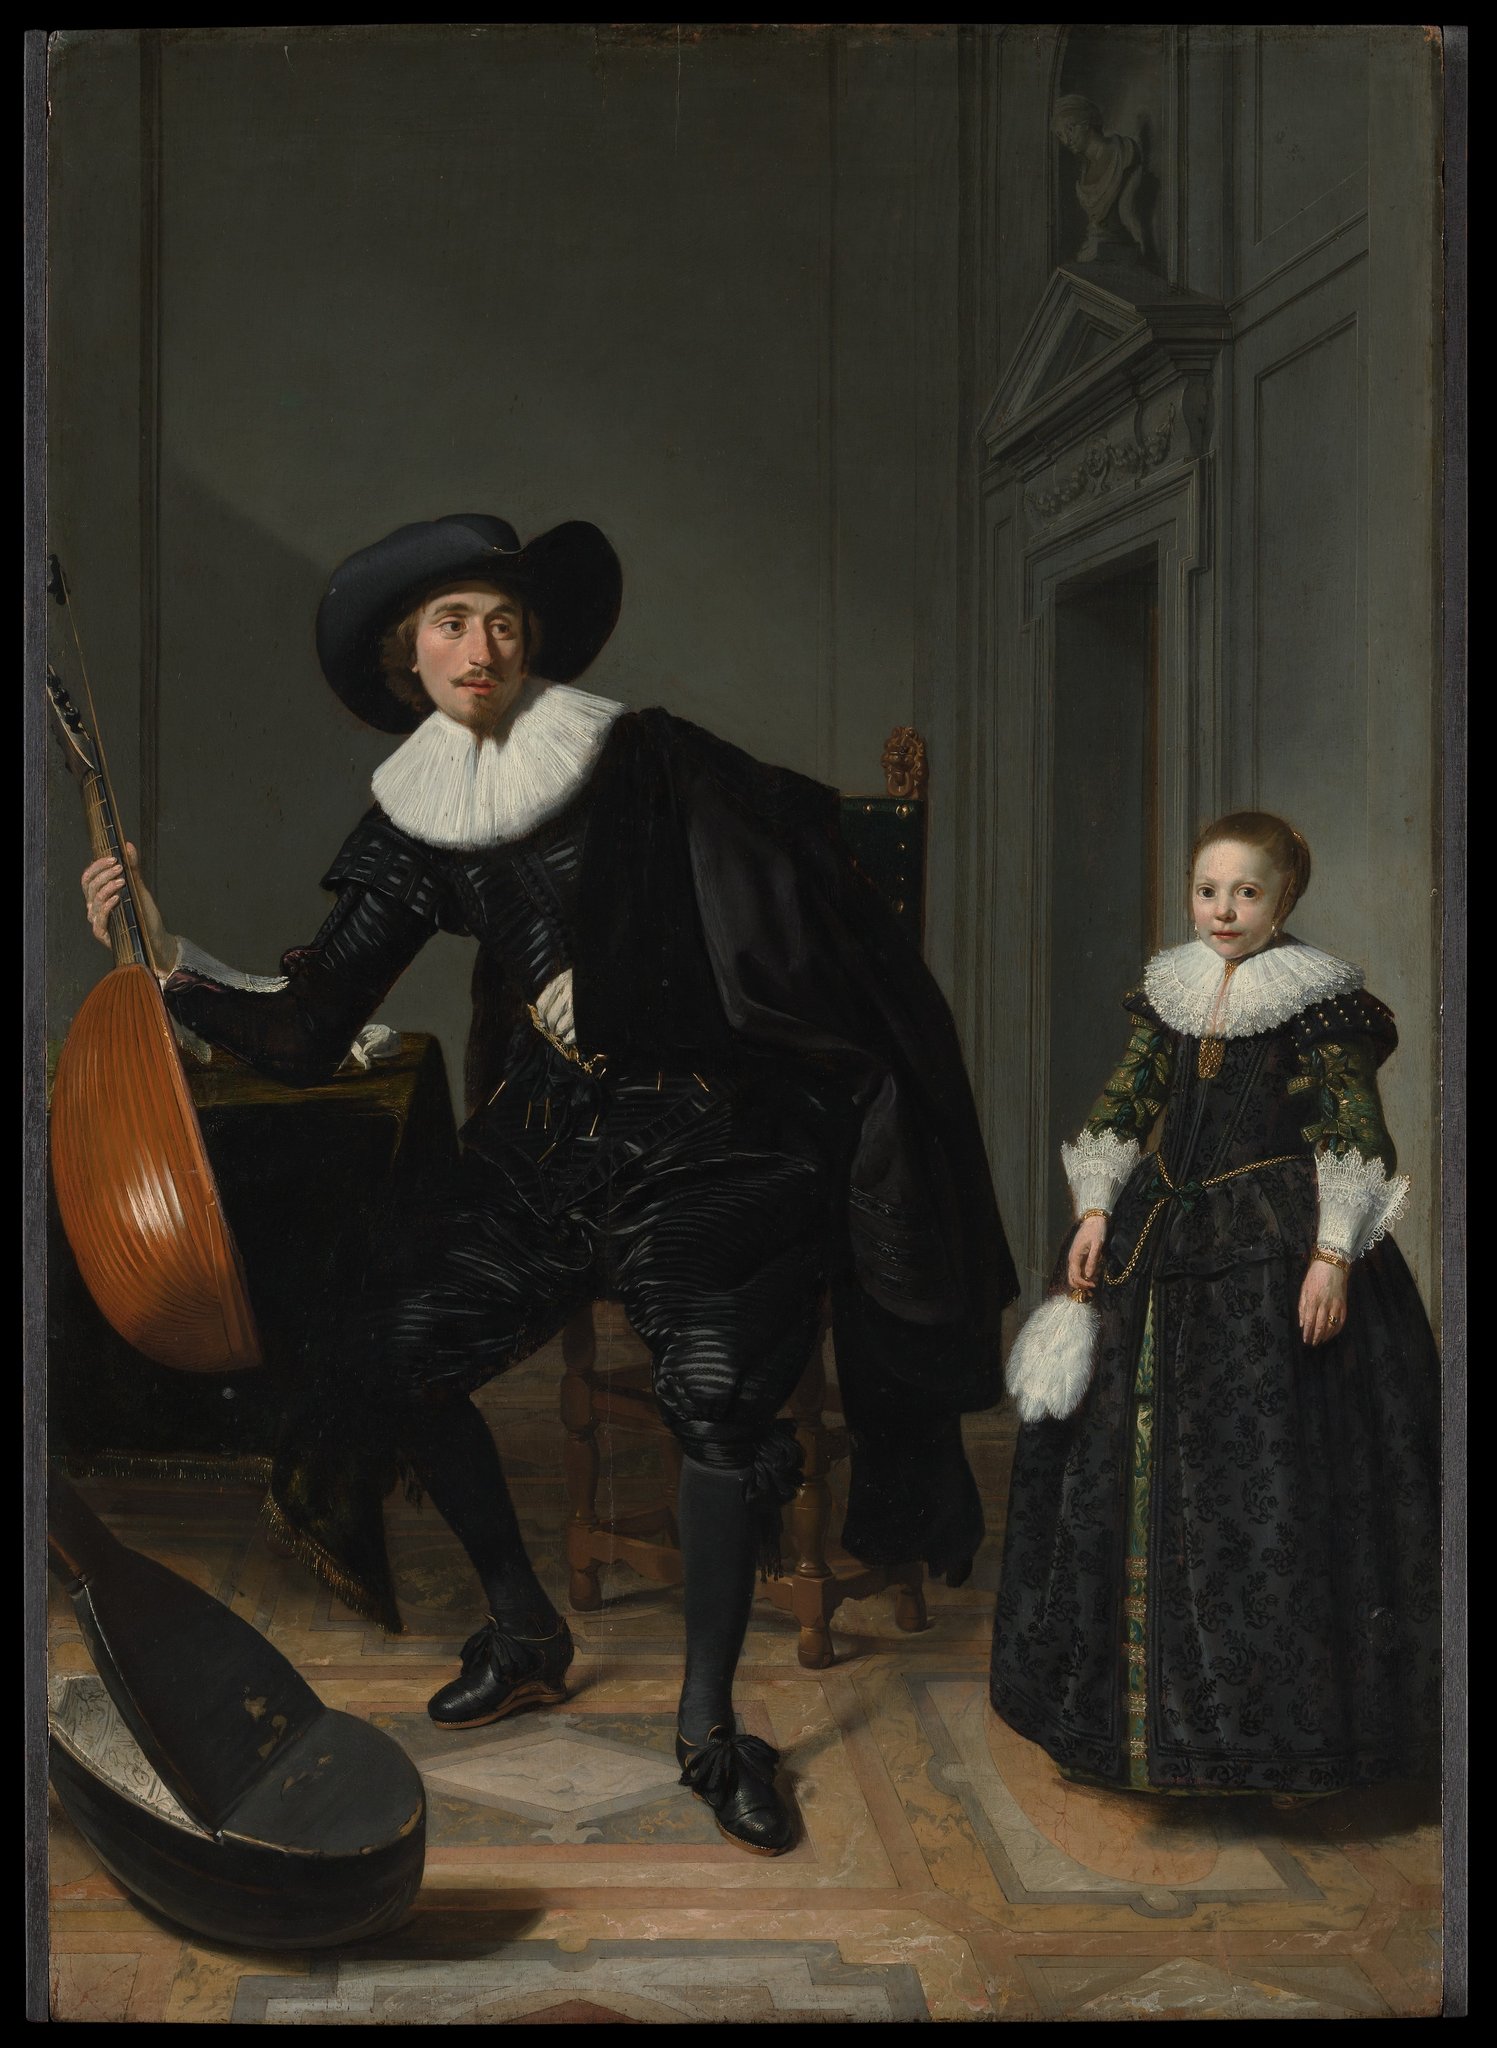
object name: painting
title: A Musician and His Daughter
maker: thomas de keyser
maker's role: artist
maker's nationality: dutch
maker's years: 1596-1667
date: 1629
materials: oil, wood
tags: girls,men,portraits,music,lutes,musicians